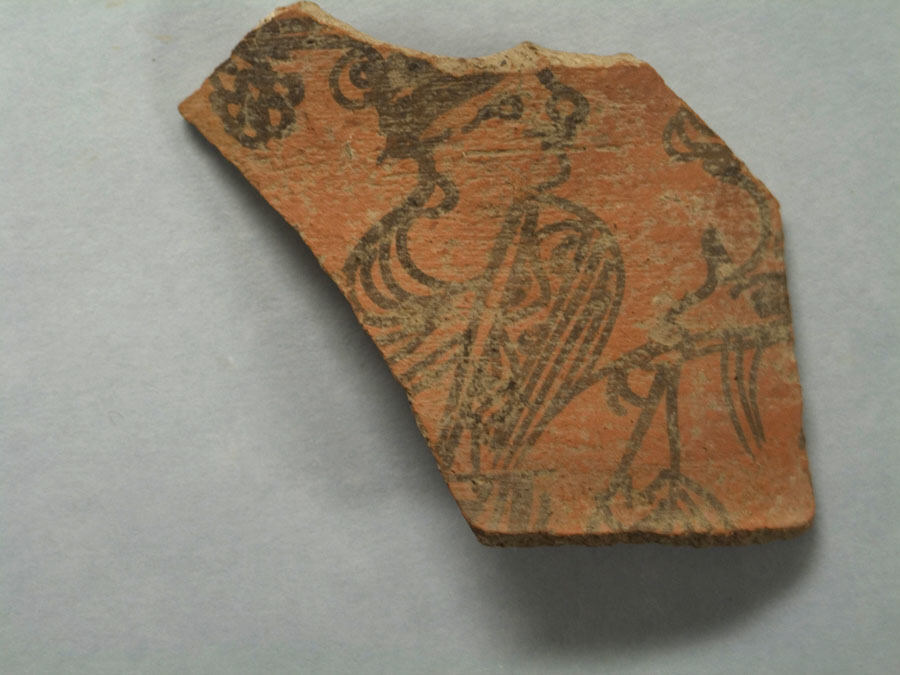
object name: shard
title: Shard: Offerer with Flower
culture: pakistani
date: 301-500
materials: terracotta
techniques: painting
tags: human figures,gandhara